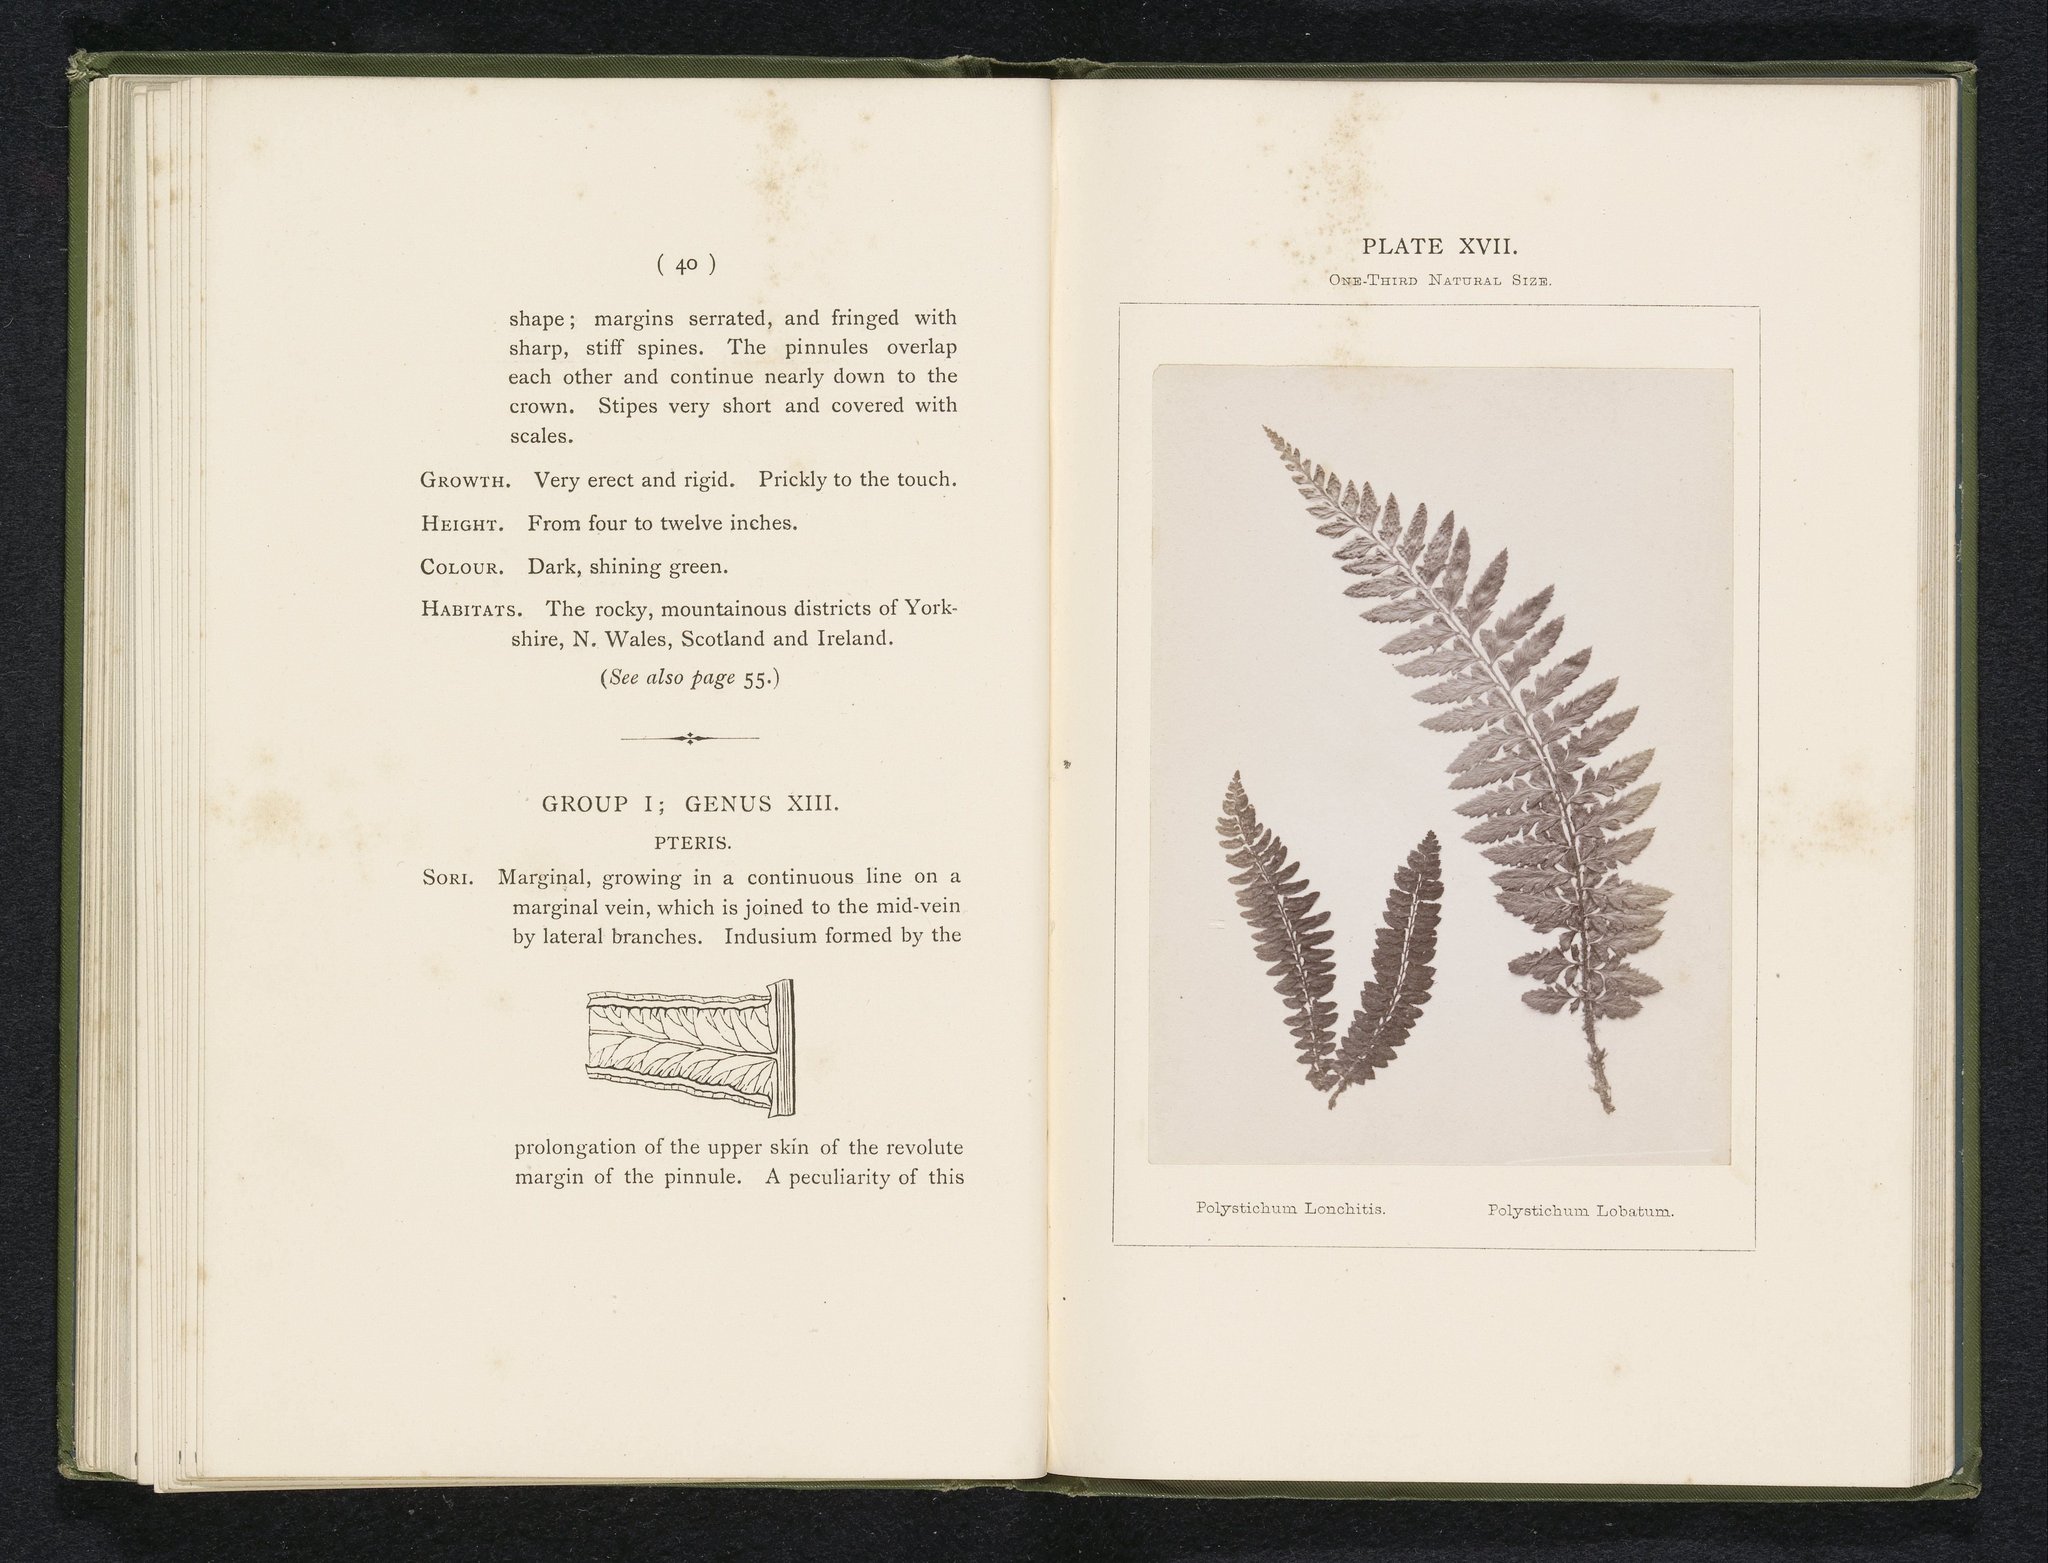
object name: page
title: Bladeren van een lansvaren en een andere naaldvaren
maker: sydney courtauld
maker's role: botanicus, fotograaf, schrijver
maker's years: 1840-1899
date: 1867-1877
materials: photographic support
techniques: albumen print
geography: england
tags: ferns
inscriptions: inscription: ‘Plate XVII. One-third natural size.’